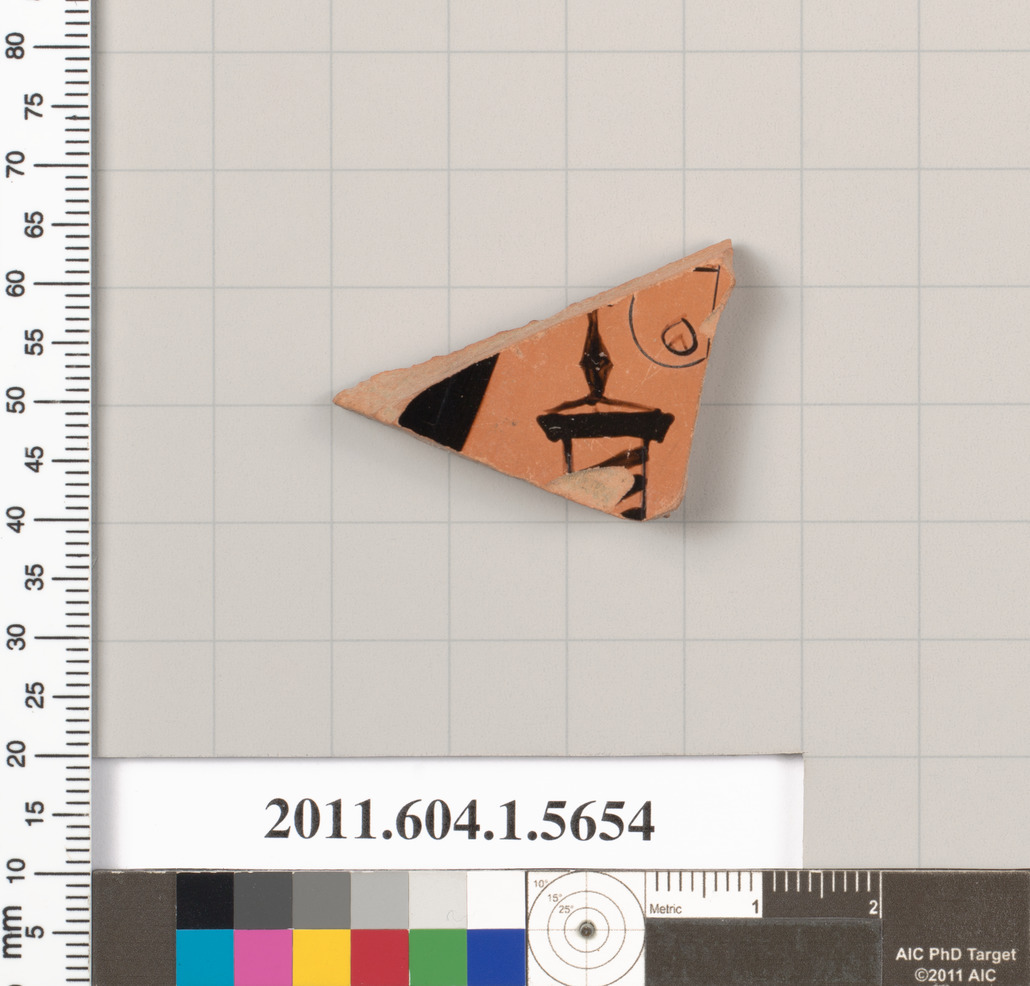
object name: kylix fragment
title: Terracotta fragment of a kylix (drinking cup)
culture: greek, attic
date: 510-490 BCE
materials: terracotta